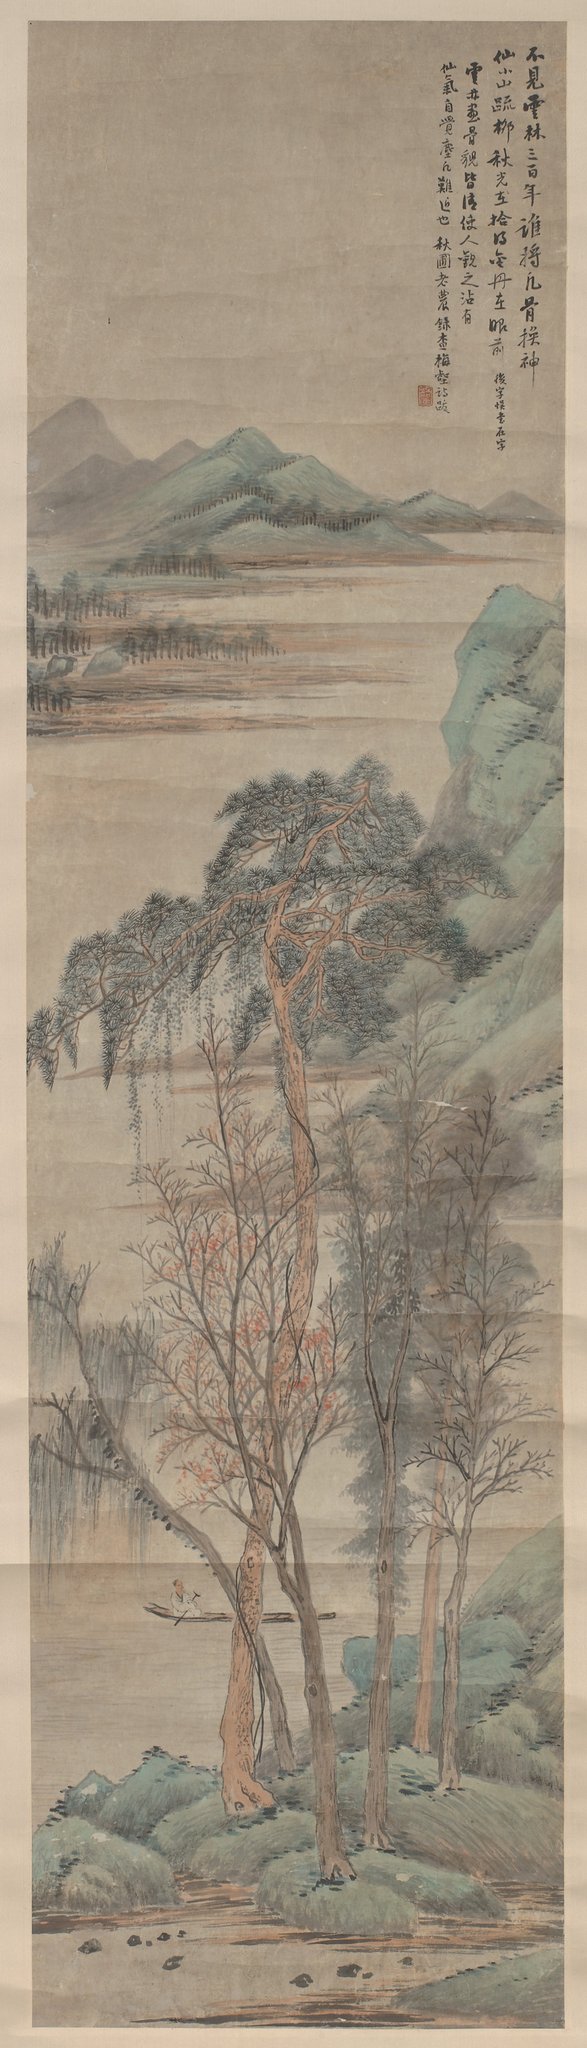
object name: hanging scroll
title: Landscape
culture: chinese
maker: wu guxiang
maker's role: artist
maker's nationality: chinese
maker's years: 1848-1903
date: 1848-1903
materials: ink, paper